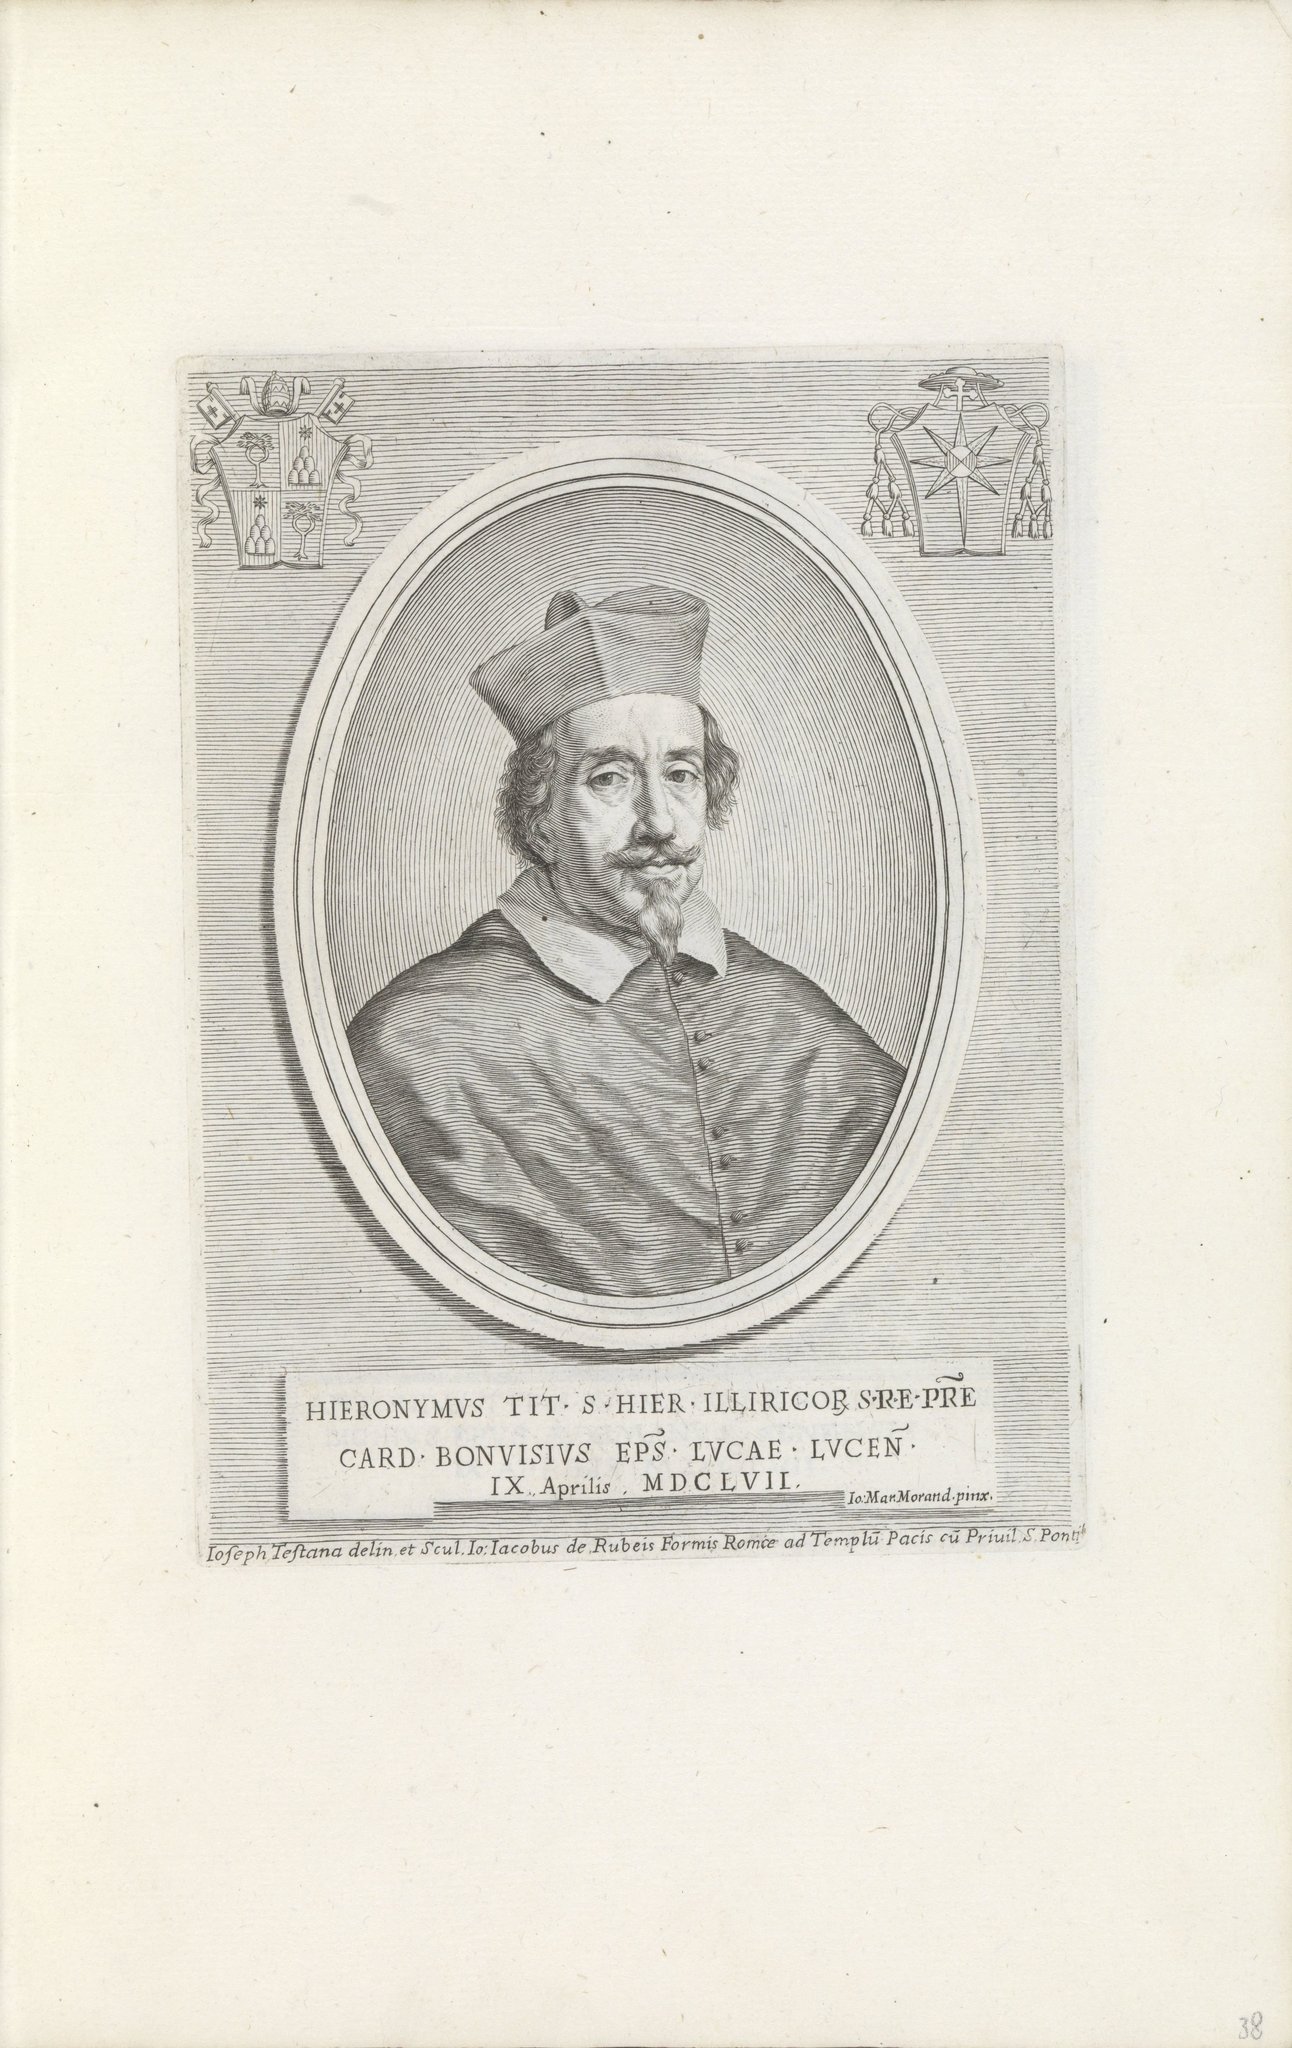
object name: album leaf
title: Effigies Nomina et Cognomina S.D.N. Alexandri Papae VII et RR. DD. SRE. Cardd (...).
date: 1658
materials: paper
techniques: engraving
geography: rome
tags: girolamo buonvisi, cardinal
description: Portret van kardinaal Girolamo Buonvisi. Linksboven het wapen van paus Alexander VII en rechtsboven het wapen van de kardinaal. Onderaan een onderschrift in het Latijn. De prent maakt deel uit van een album.